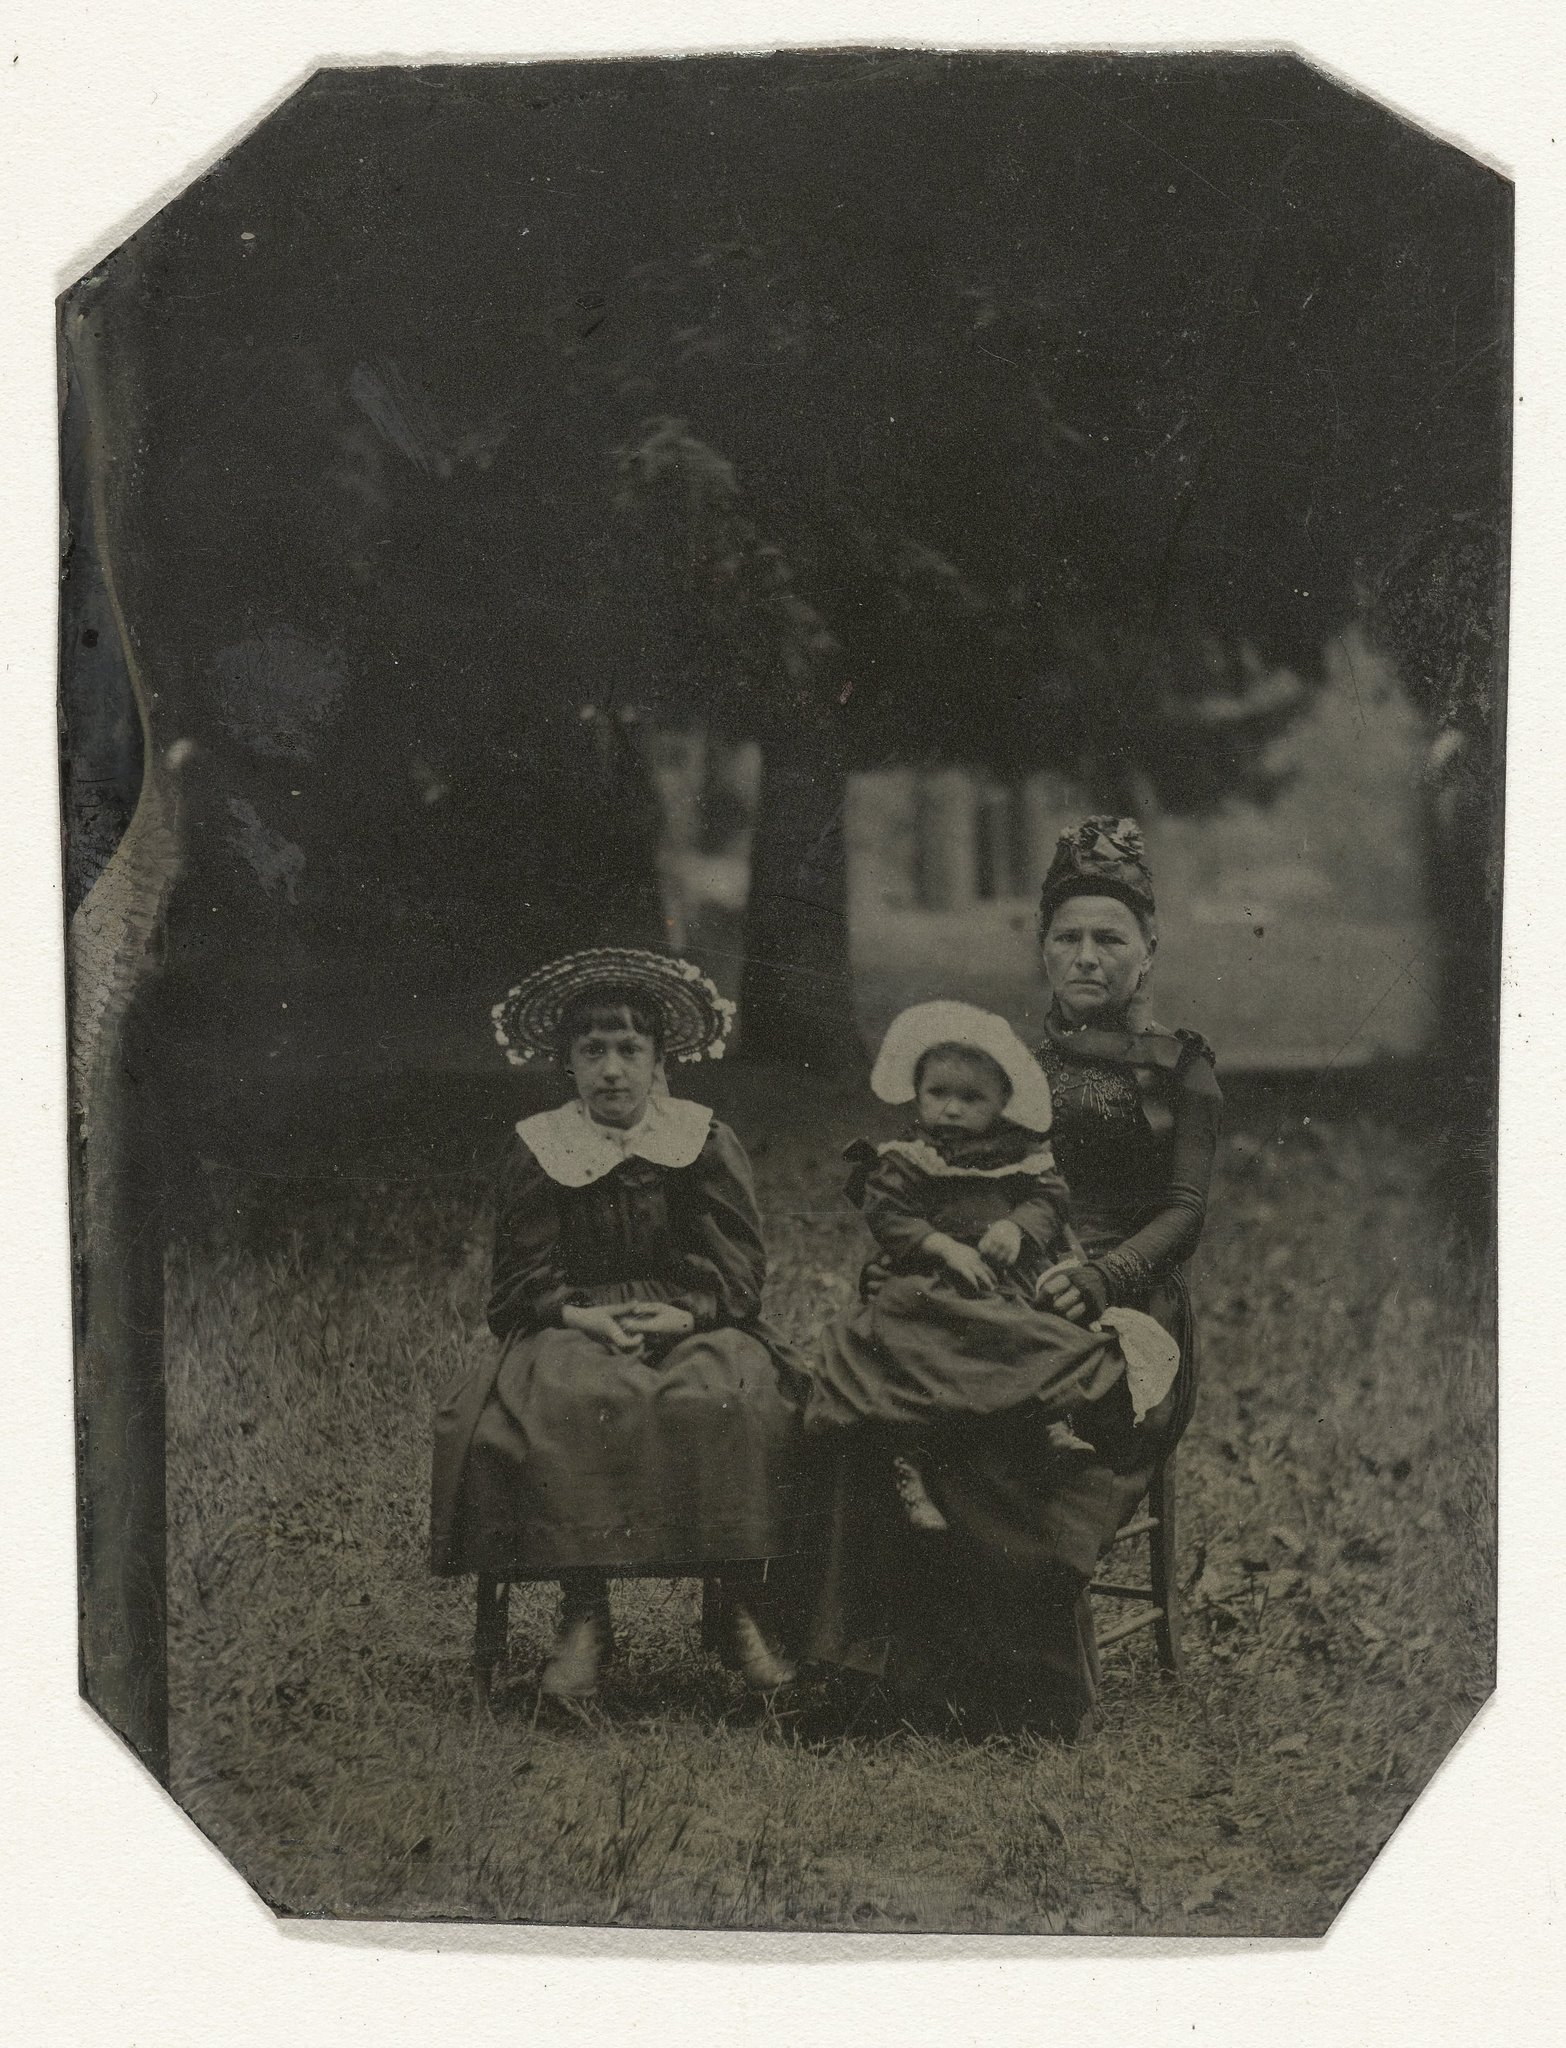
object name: photograph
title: Portret van een vrouw, een meisje en een klein kind, op stoelen zittend in een bos (?)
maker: Anonymous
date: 1880-1900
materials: metal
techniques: ferrotyping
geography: united states